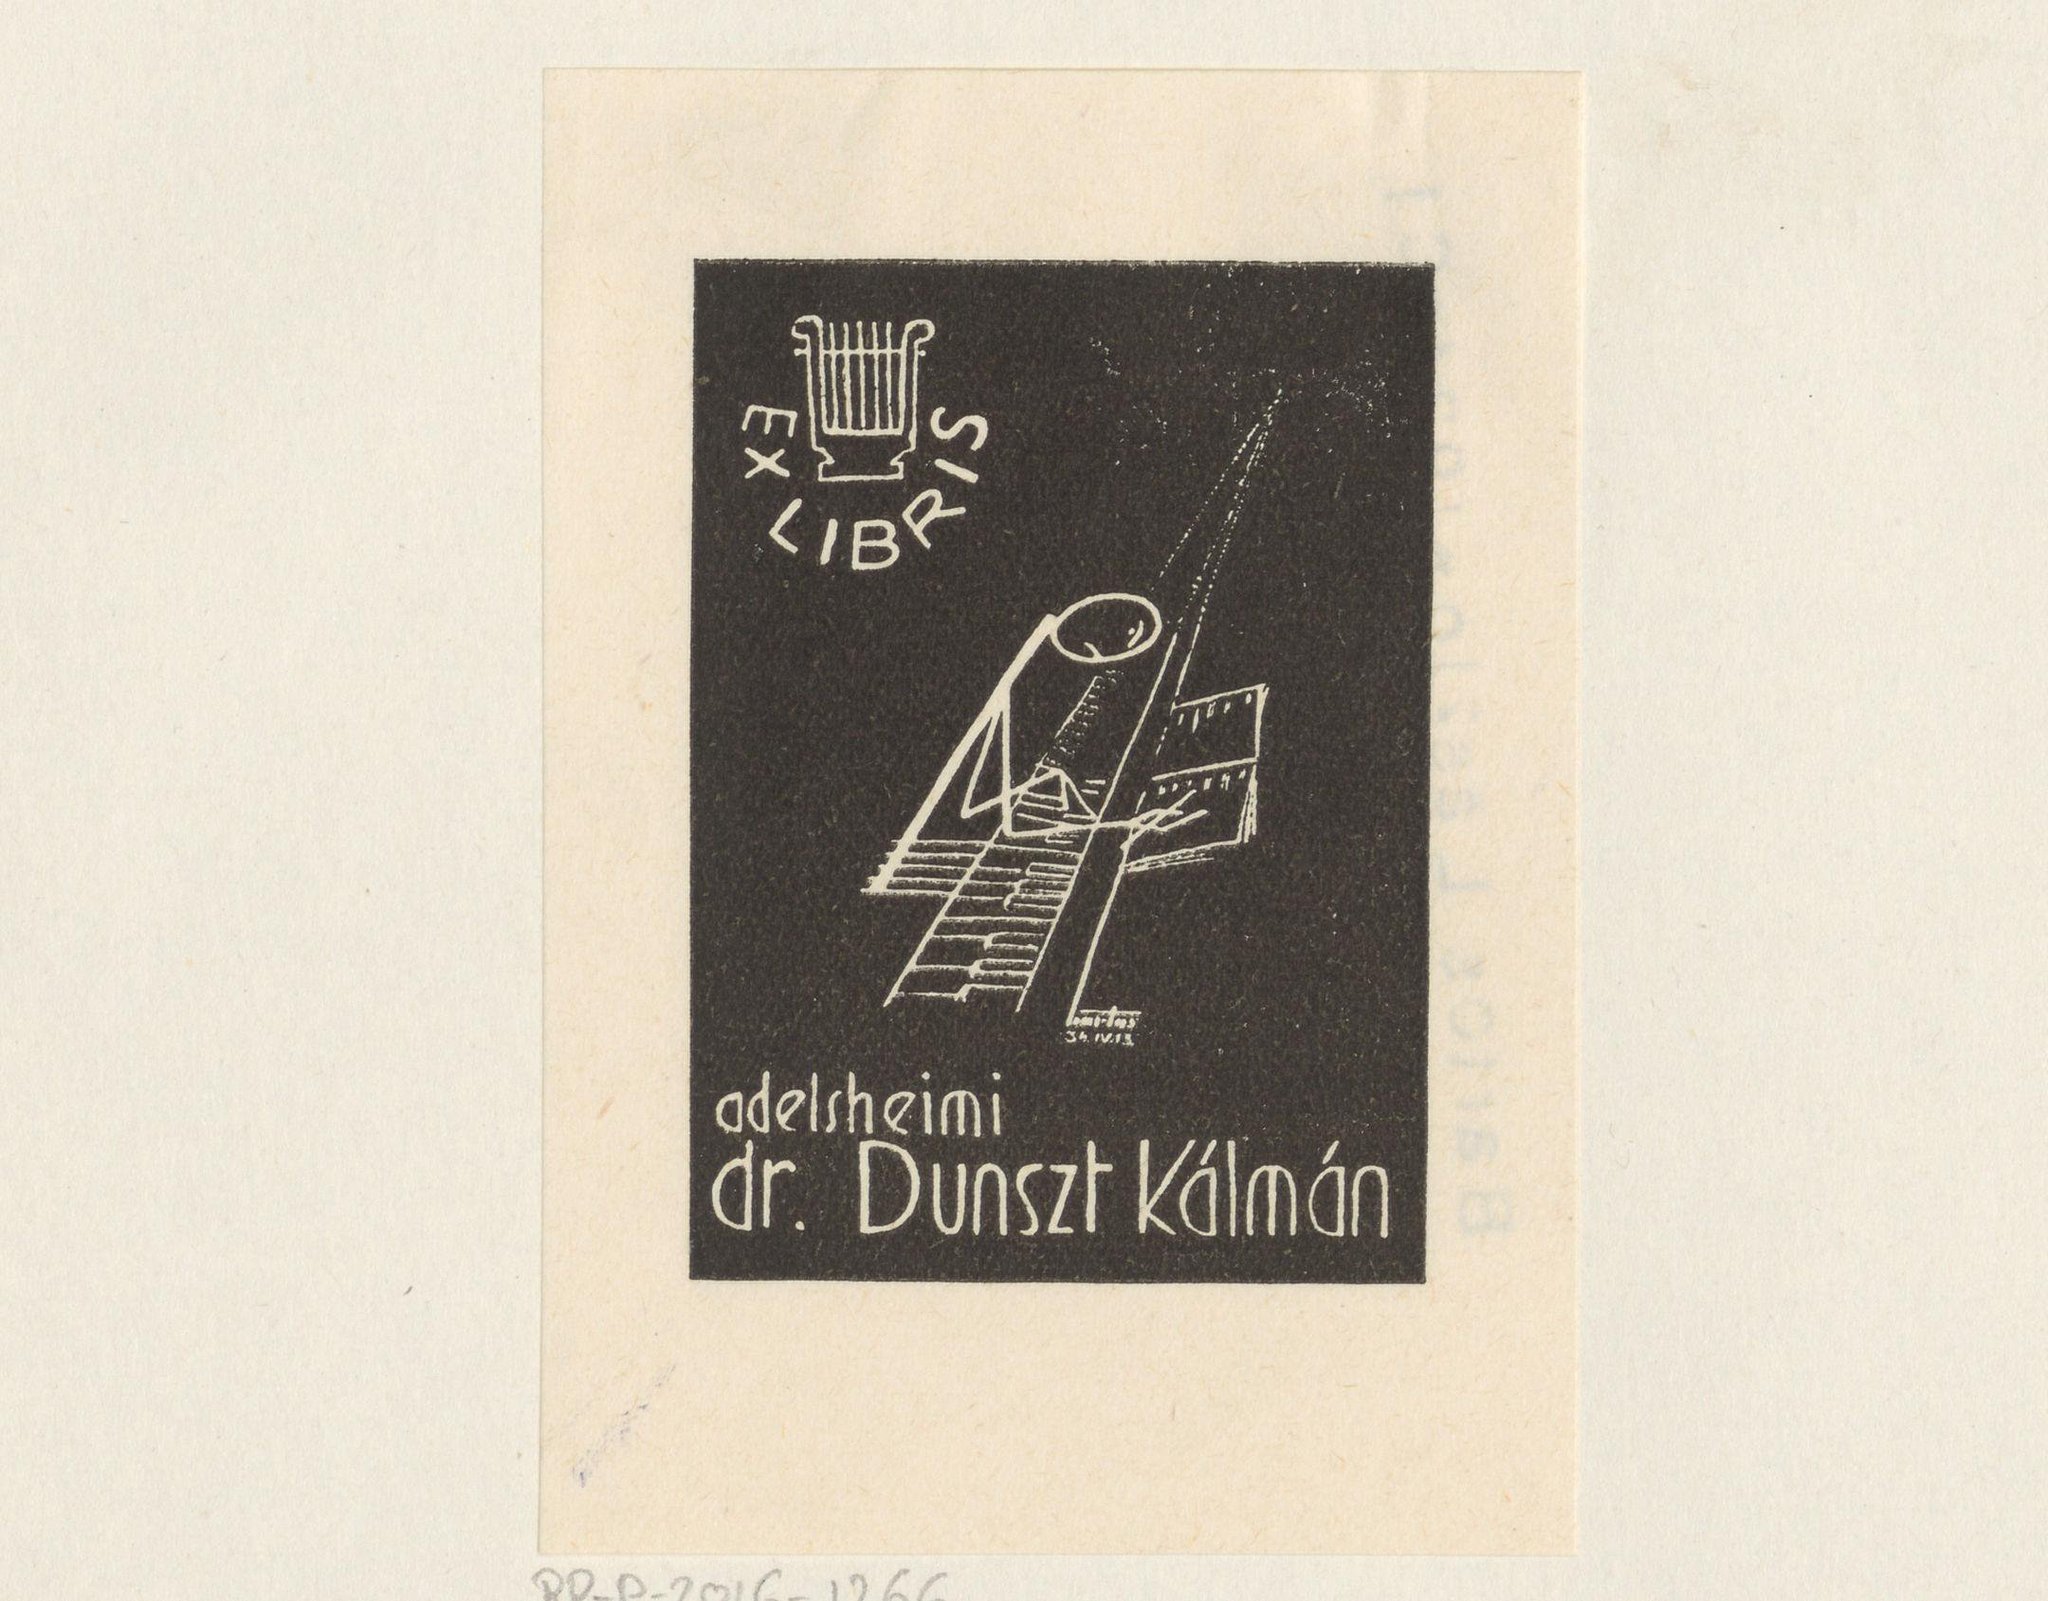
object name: bookplate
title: Ex libris van dr. Dunszt Kálmán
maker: lászló bartos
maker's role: print maker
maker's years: 1902-1943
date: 1934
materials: paper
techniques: printing block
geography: hungary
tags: one person playing keyboard instrument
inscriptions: workshop stamp: ‘Bartos László.1934.Cl’